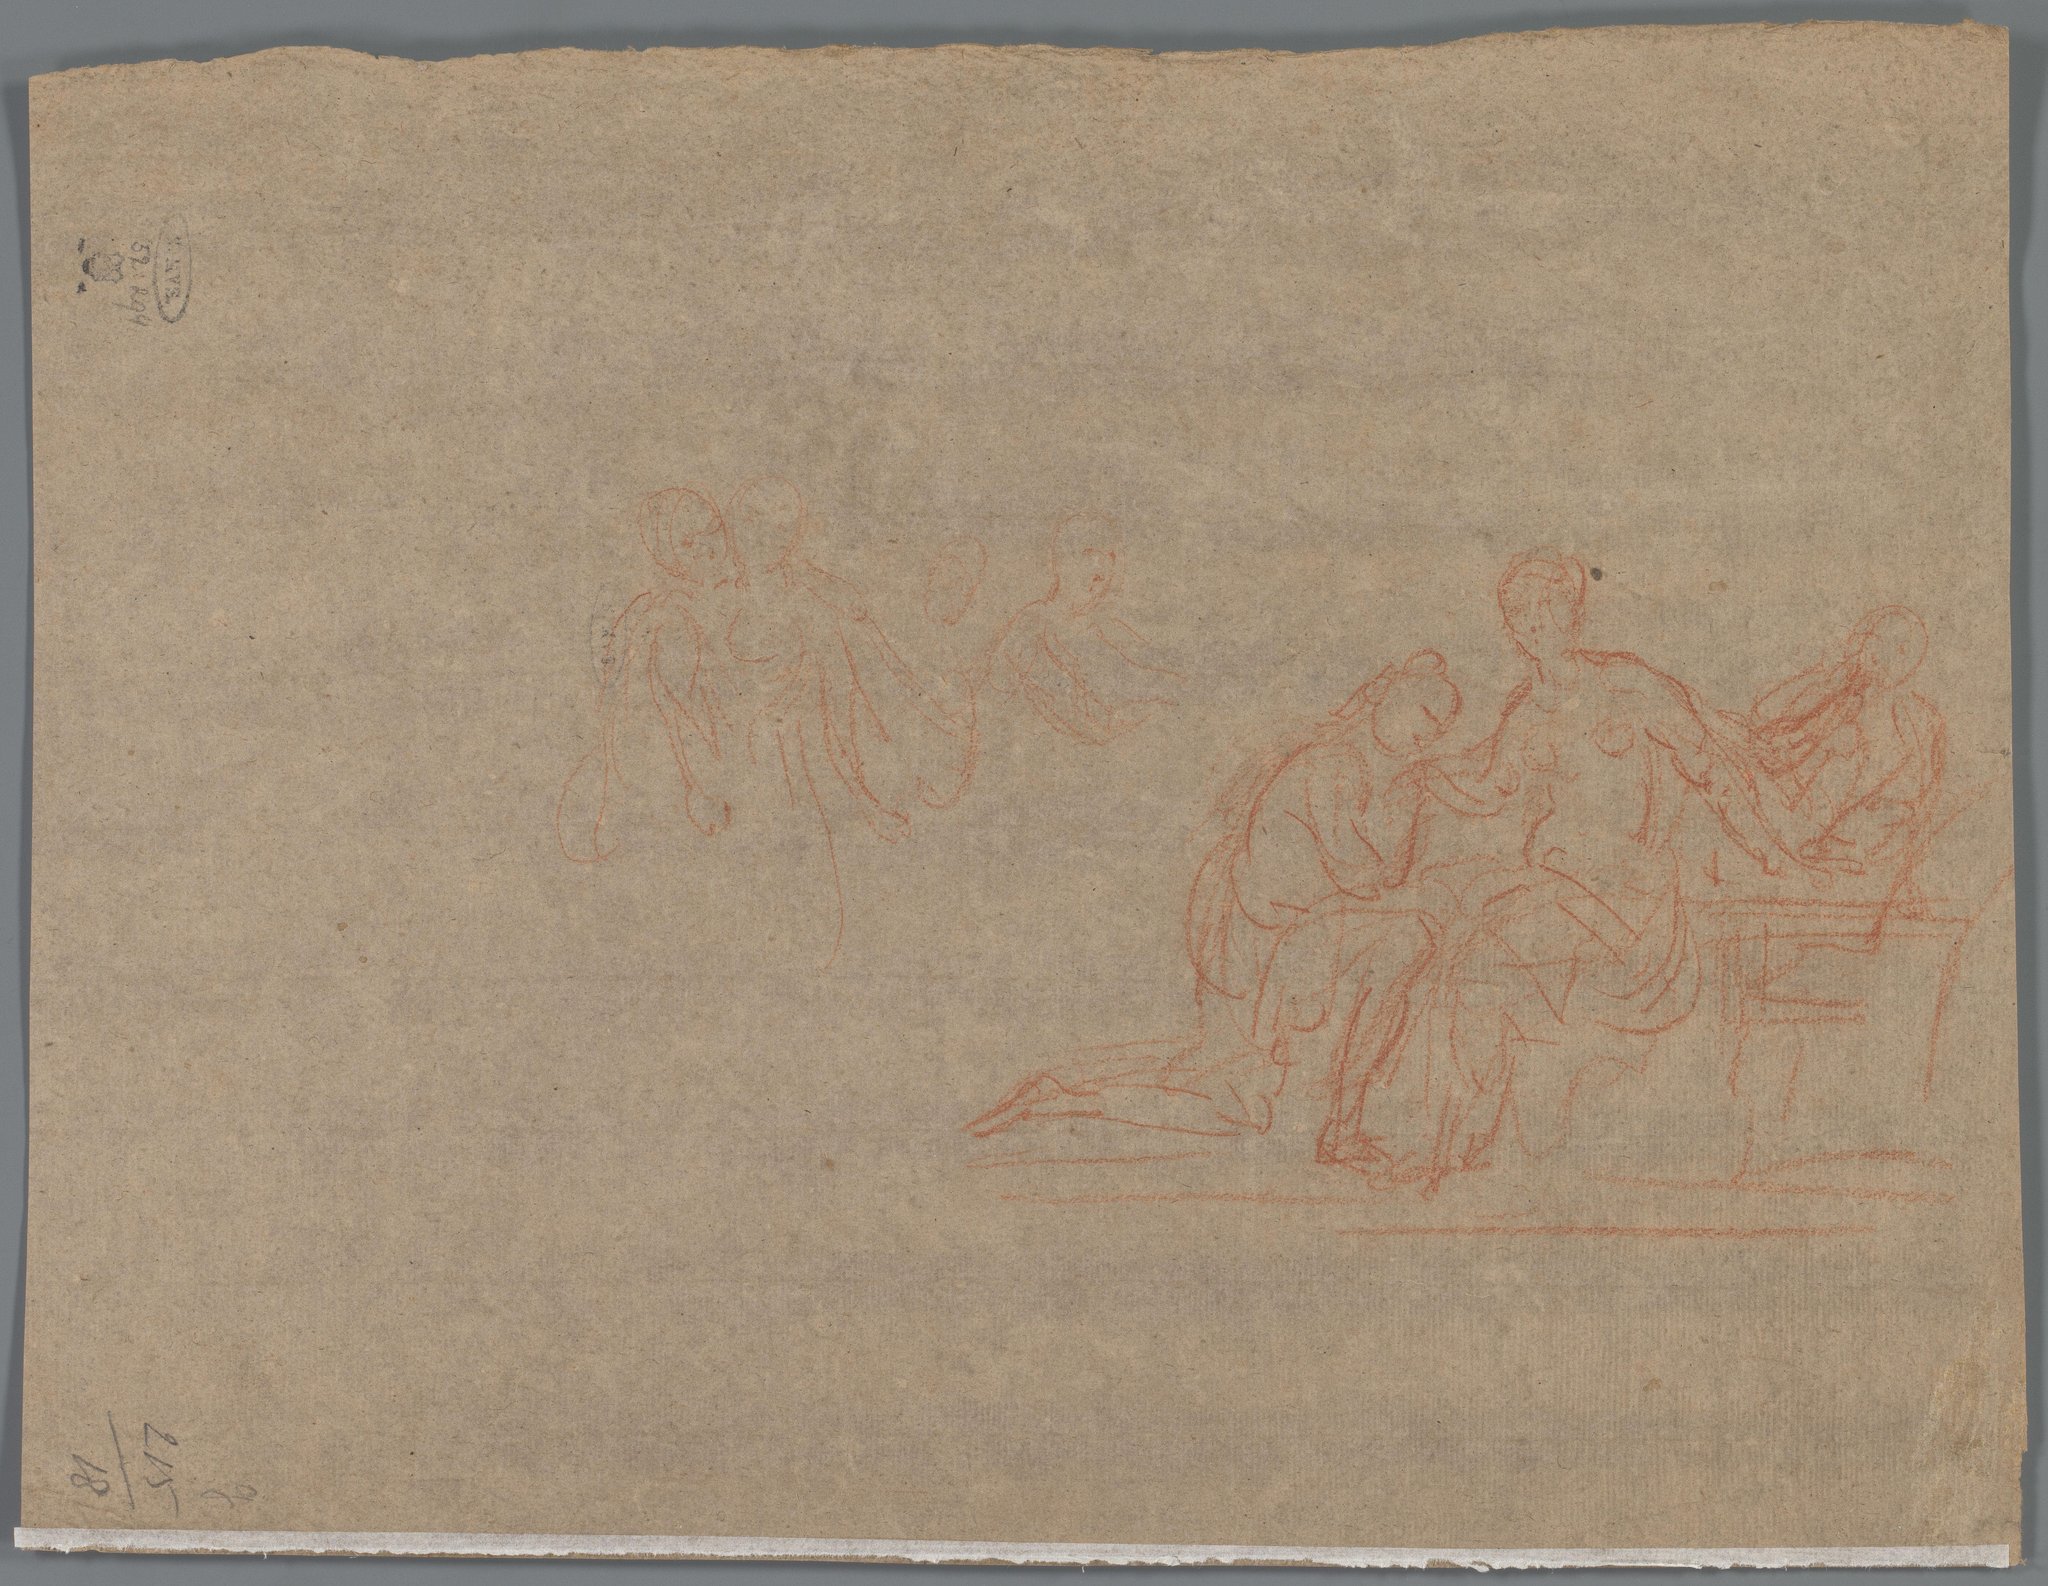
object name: drawing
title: Half ontklede vrouw ontvangt het huldebetoon van twee mannen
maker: Anonymous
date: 1700-1800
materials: chalk, paper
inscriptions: annotation, lower right, pencil: ‘215/18’, collector's mark, lower left: Lugt 2228, collector's mark, lower left: Lugt 2760